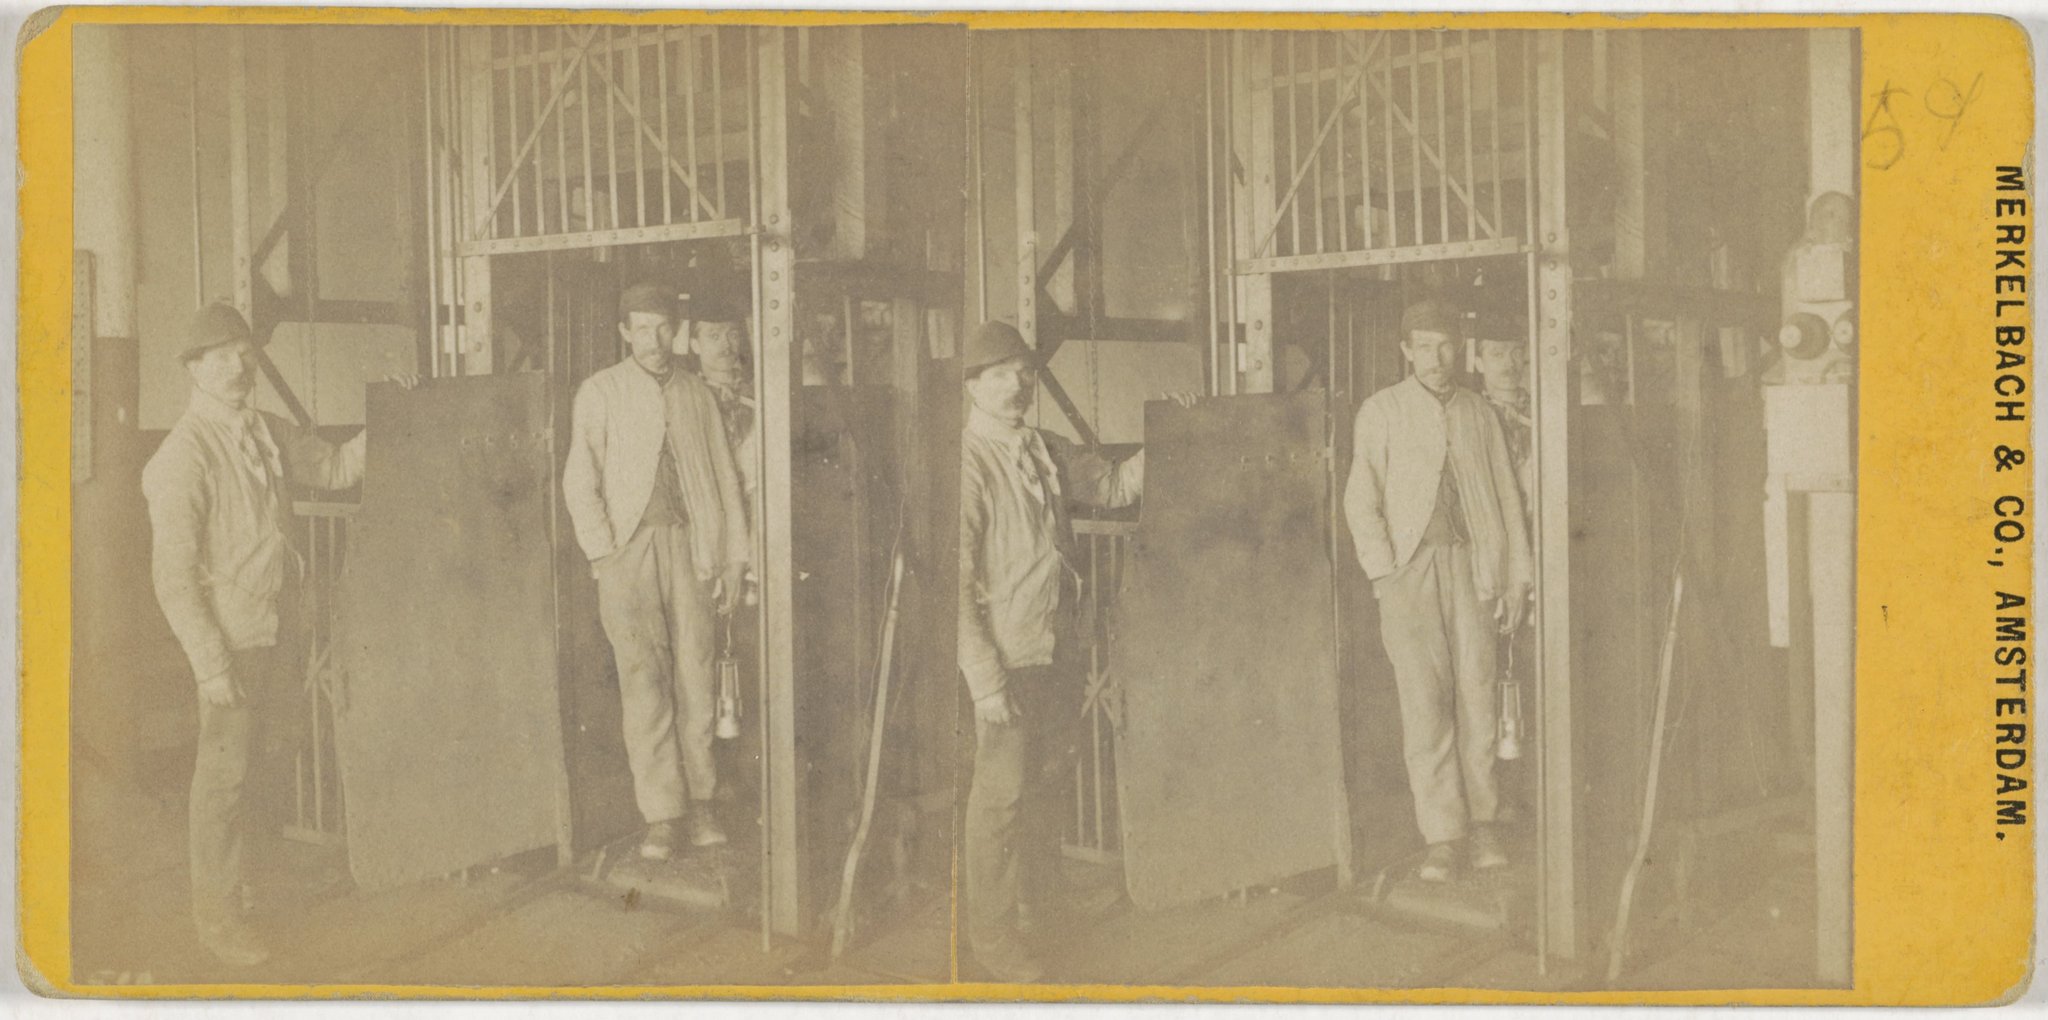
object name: stereograph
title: Mijnwerkers in een lift in een steenkolenmijn bij Kerkrade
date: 1900-1902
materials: cardboard, paper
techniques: albumen print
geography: amsterdam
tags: miner, shafts and galleries (of a mine), mine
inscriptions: number: ‘F.19.’, inscription: ‘bij Kerkrade. Mijnwerkers, gereed, om neer te dalen, de lamp in de hand./ Straks wordt de ijzeren deur gesloten en laat men de lift zakken.’, number: ‘19.’, inscription: ‘57’